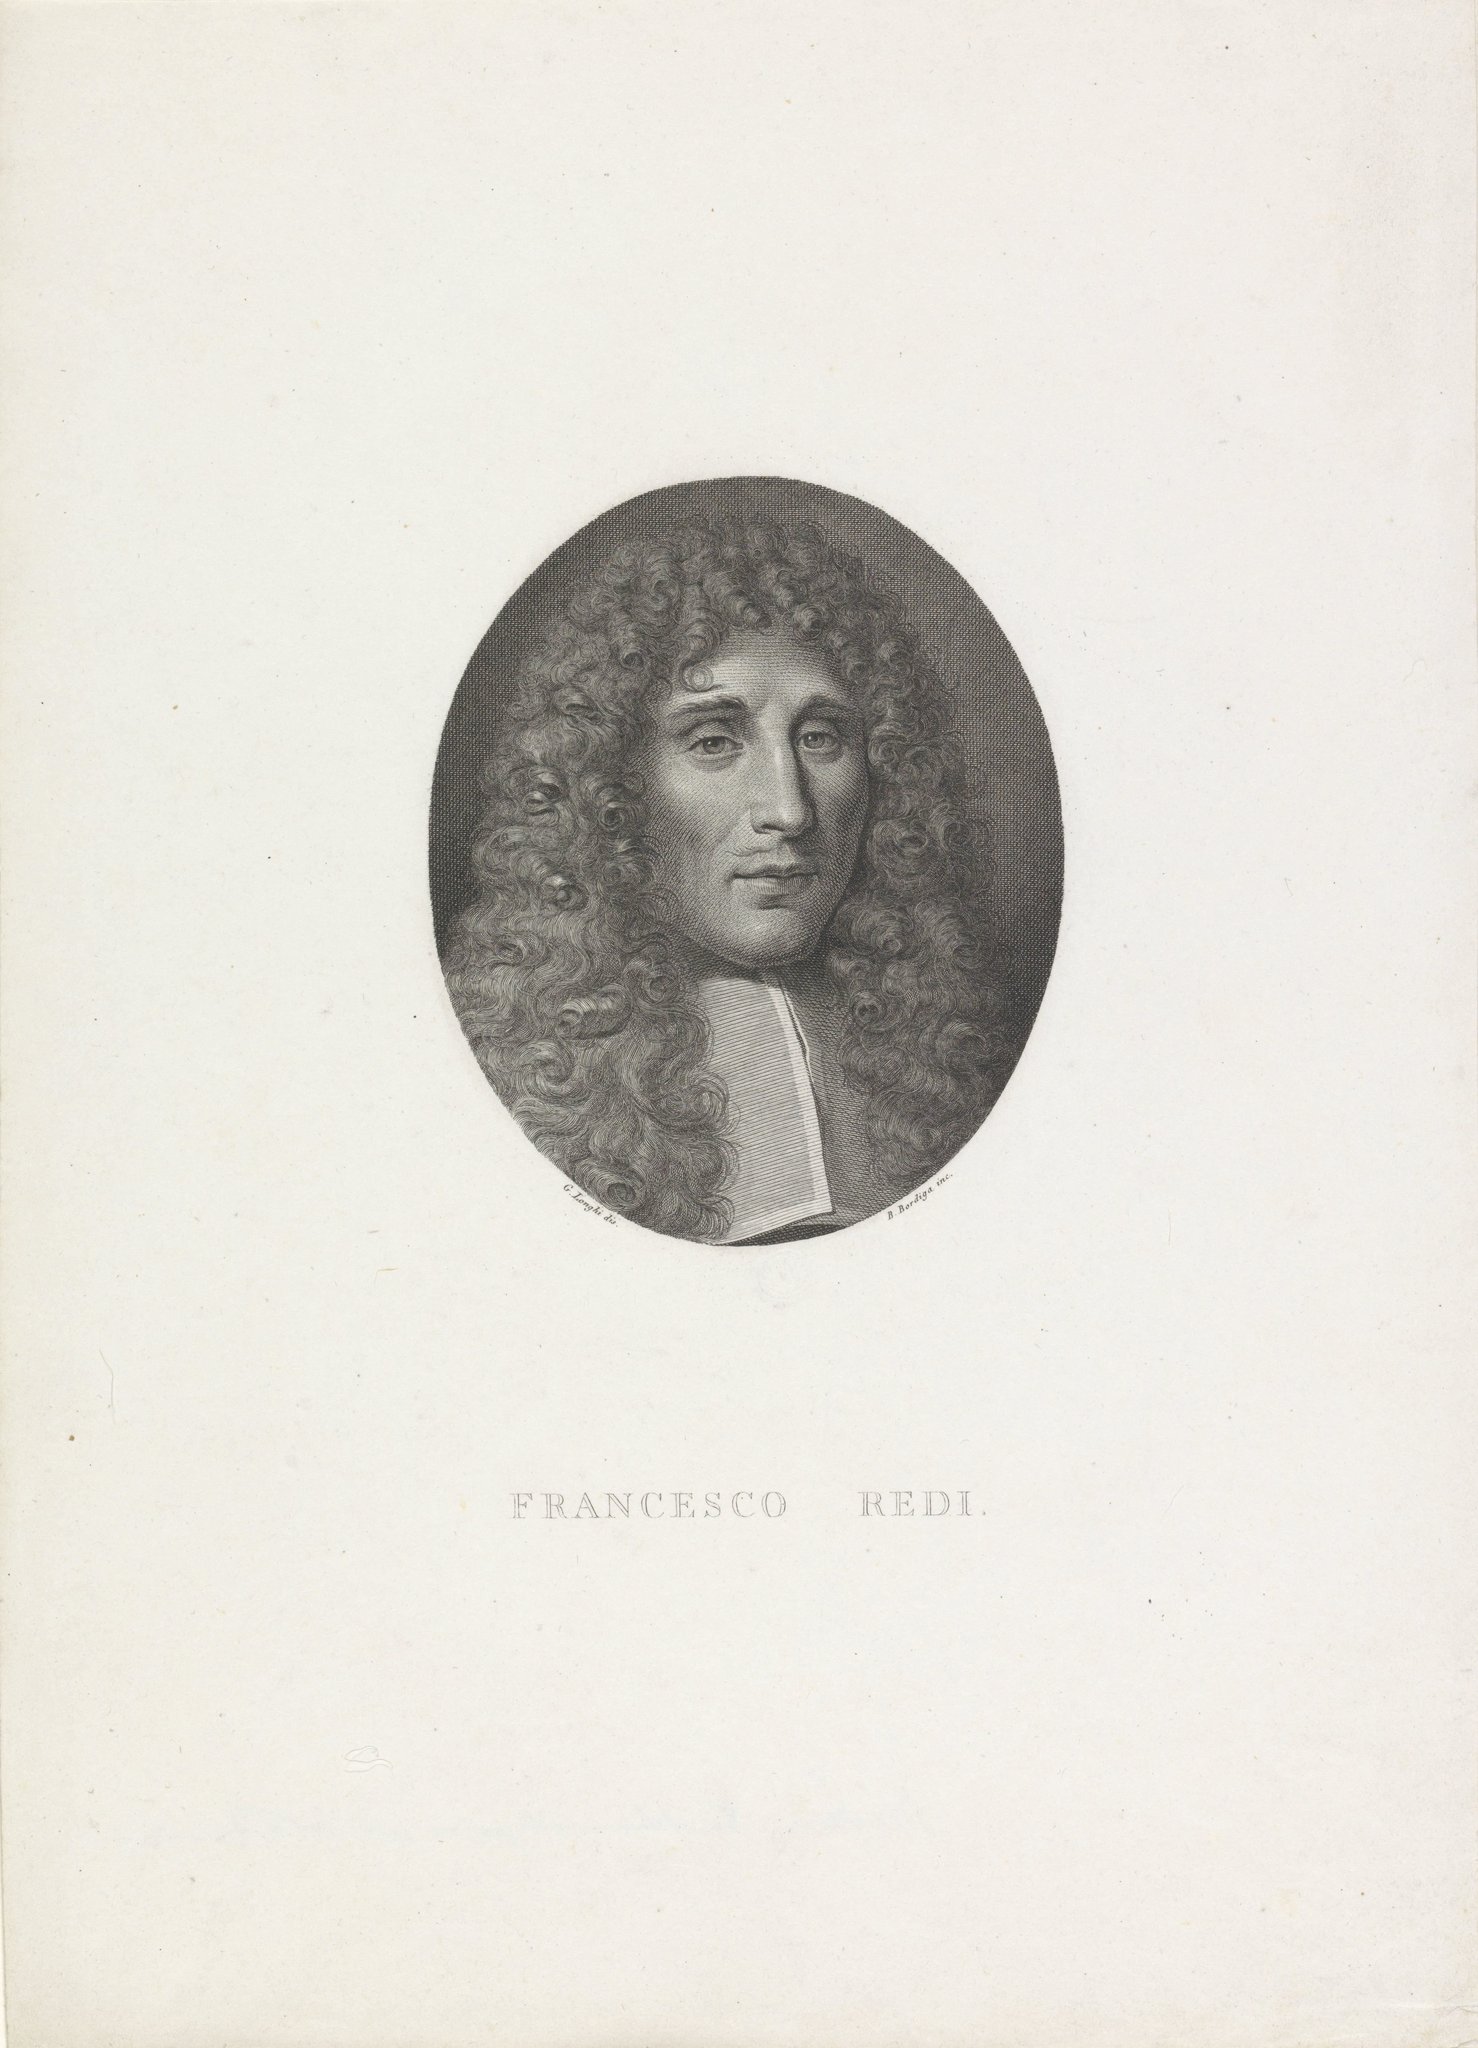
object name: print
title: Portret van arts, bioloog en dichter Francesco Redi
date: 1801-1839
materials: paper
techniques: engraving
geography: italy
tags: historical persons, portrait of a writer, writer, poet, author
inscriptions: collector's mark: Lugt 2228, collector's mark: Lugt 4187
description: Deze prent maakt deel uit van een reeks portretprenten van onbekende omvang. De reeks is in meerdere staten uitgegeven. De eerste staat met enkel het portret in ovaal. Een tweede staat met naam van de geportretteerde in holle letters onder de voorstelling. Een derde staat met de naam van de geportretteerde in gevulde letters onder de voorstelling. En een vierde staat met een rechthoekig kader rondom het ovale portret.